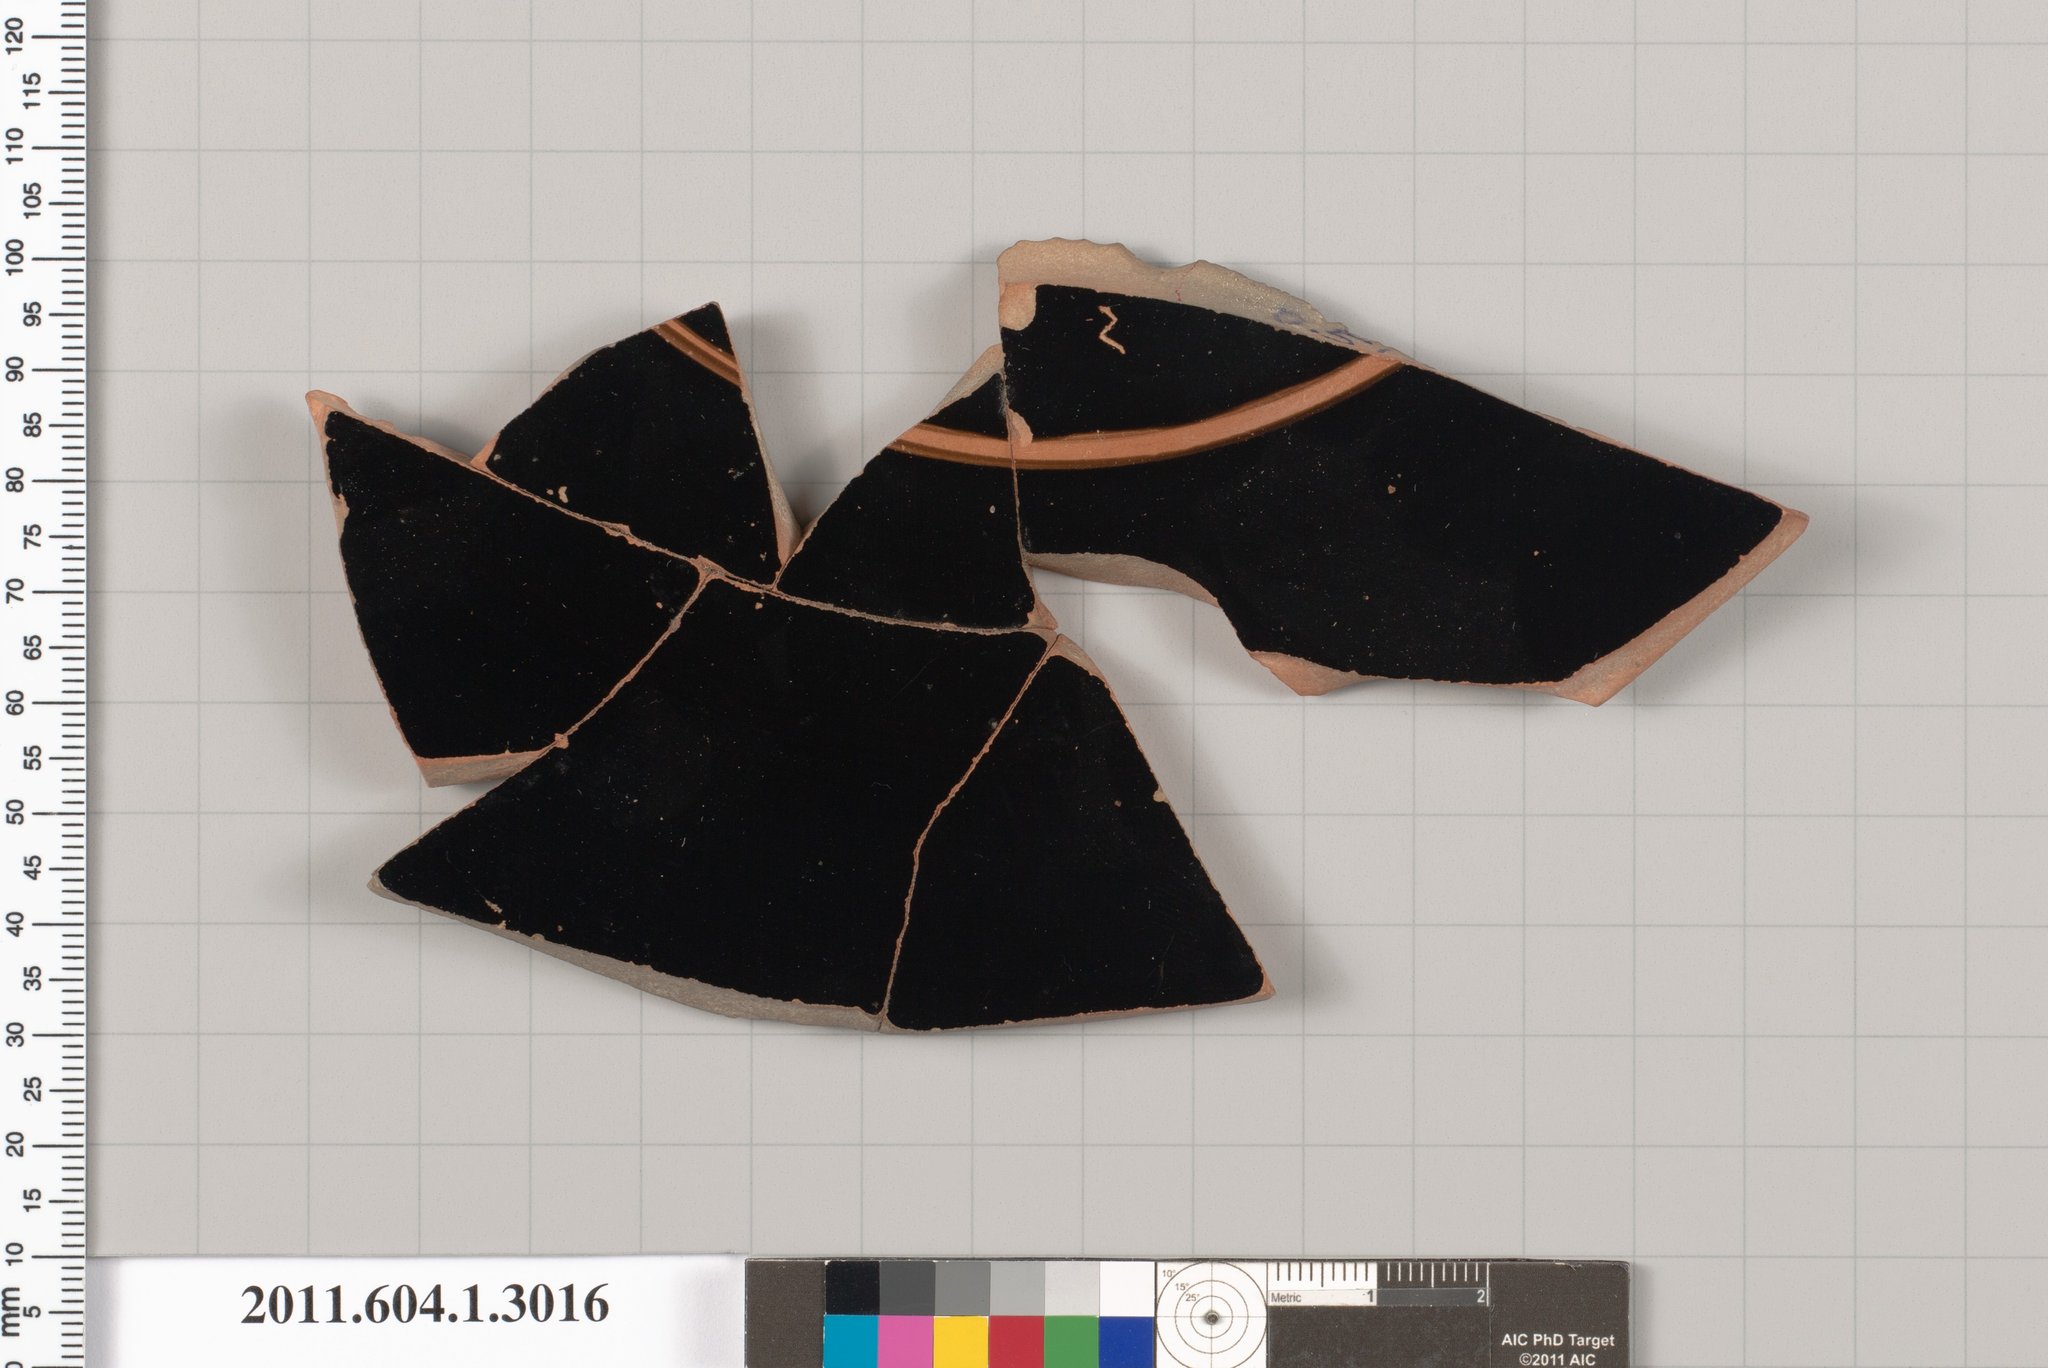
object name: kylix fragment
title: Terracotta fragment of a kylix (drinking cup)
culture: greek, attic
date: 520-500 BCE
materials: terracotta